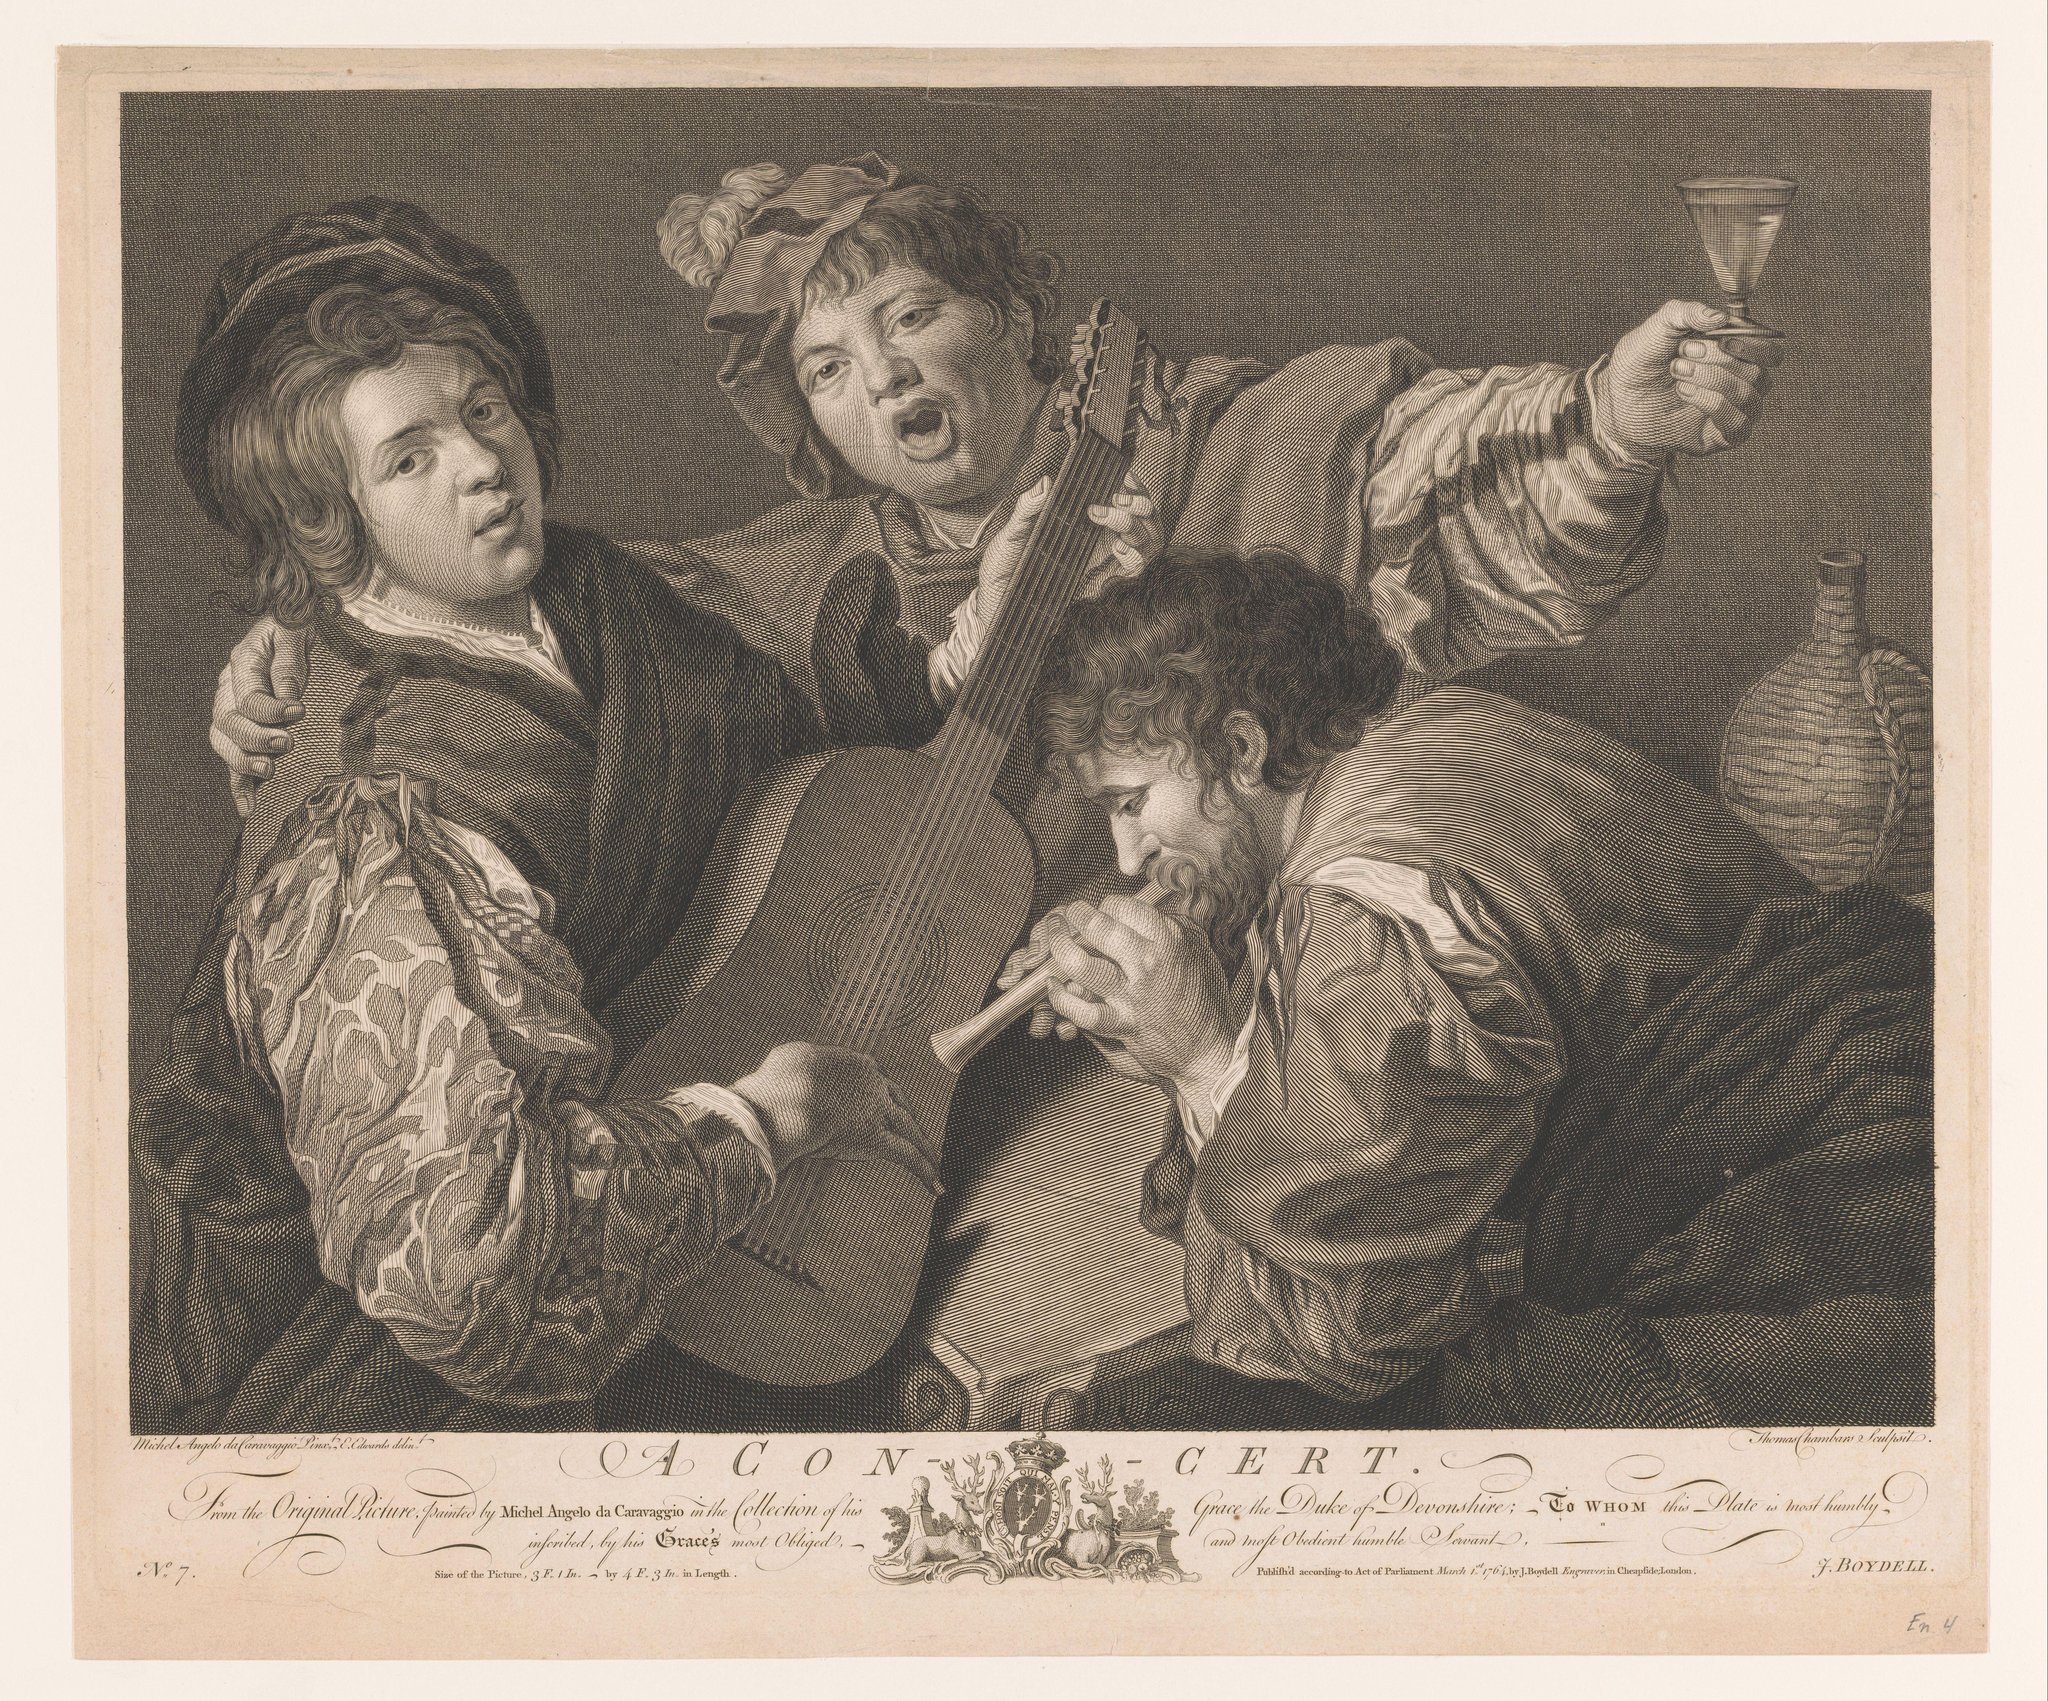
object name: print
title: A Concert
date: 1703-1764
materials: paper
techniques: engraving, etching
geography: london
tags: musician(s) accompanying singer(s), cithern, mandolin, guitar, balalaika, flute, aulos, tibia, more than one musician with instrument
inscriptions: collector's mark: Lugt 2228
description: Het schilderij is gemaakt door Valentin de Boulogne en niet door Caravaggio, zoals op de prent staat. Vanaf 1763 tot 1786 publiceerde John Boydell prenten naar schilderijen uit Engelse collecties. Deze waren vanaf 1769 gebonden verkrijgbaar.